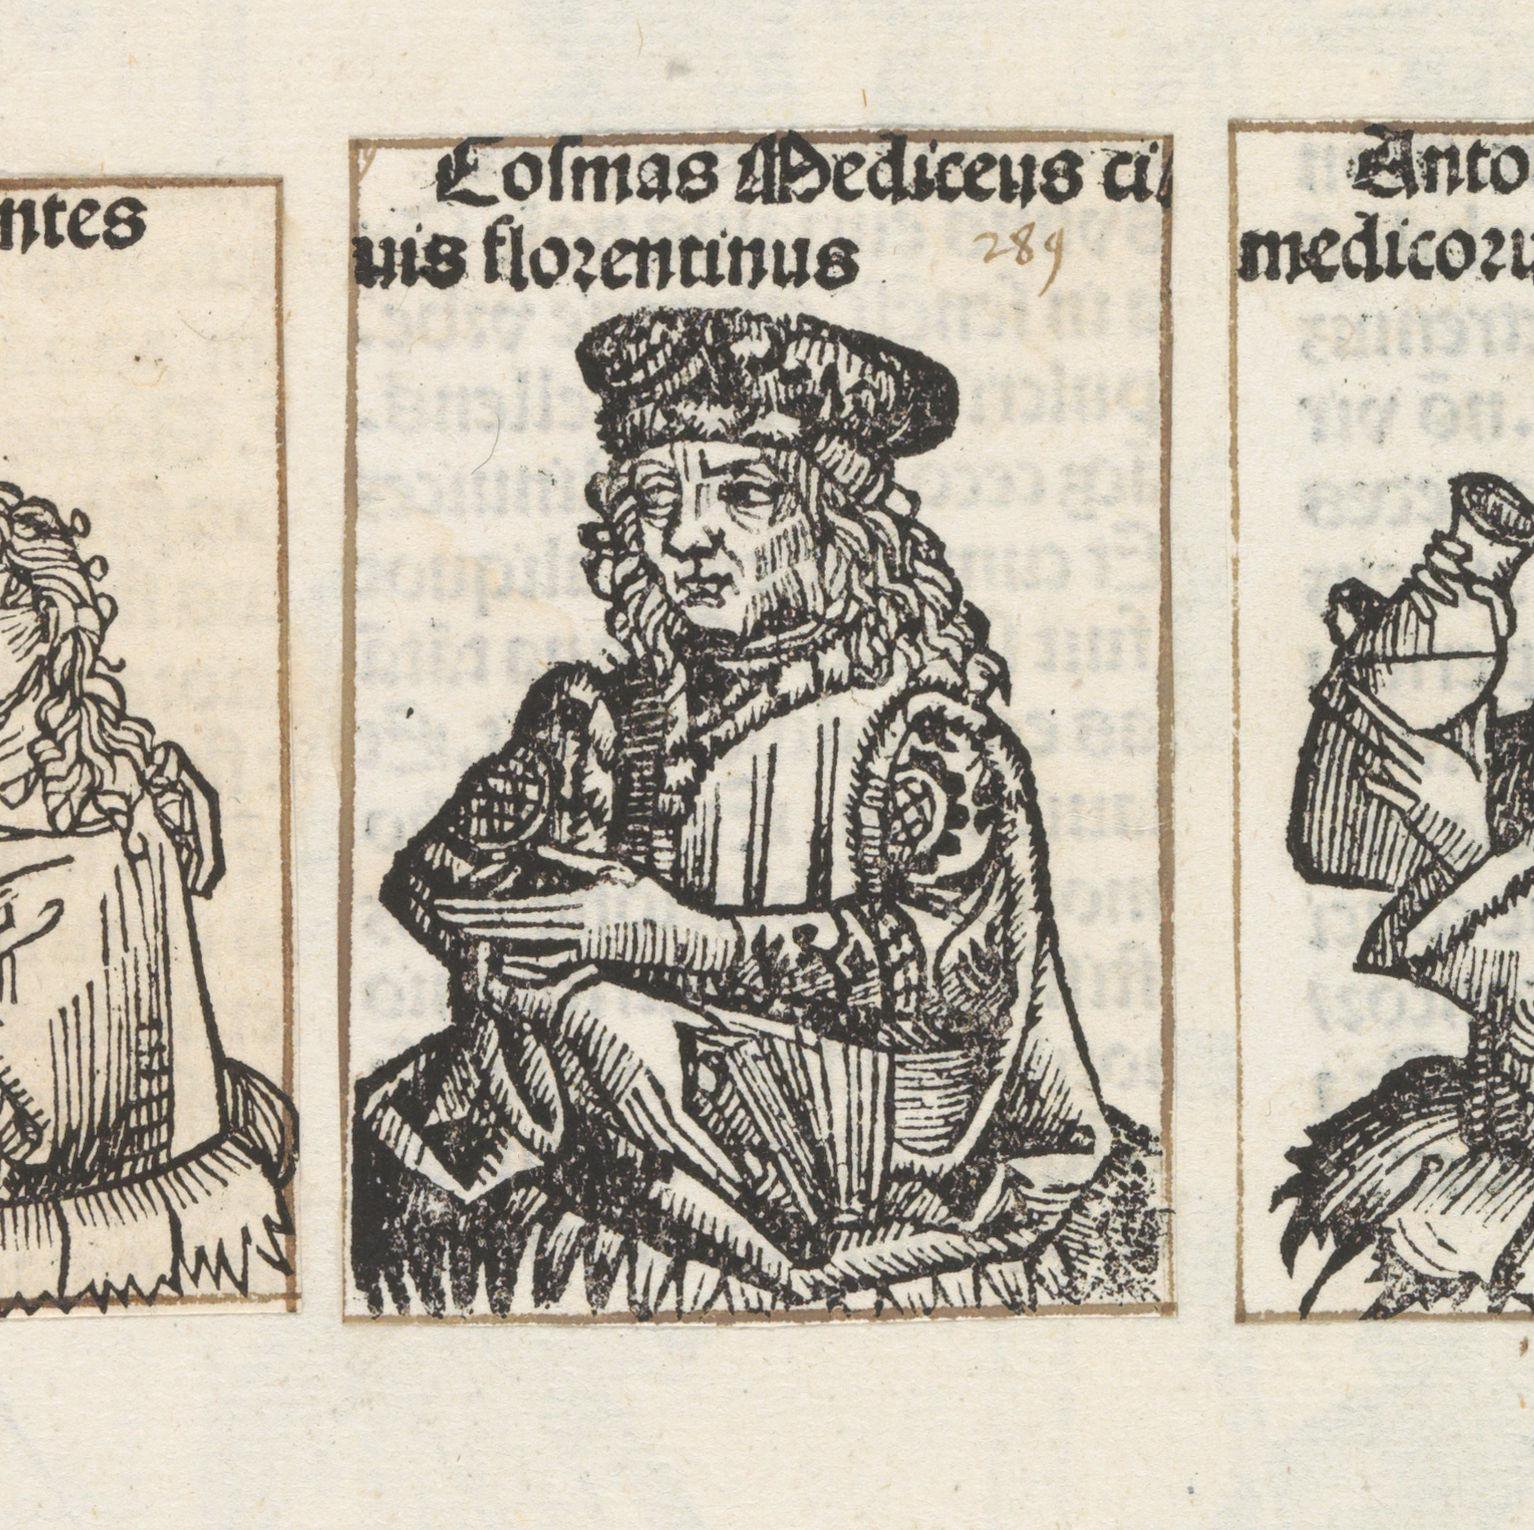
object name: print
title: Cosmas Mediceus civis florentinus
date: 1493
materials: paper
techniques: letterpress printing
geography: nuremberg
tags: politician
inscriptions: inscription: ‘289’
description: De houtsnede wordt herhaaldelijk gebruikt als boekillustratie in de Liber Chronicarum (of Neurenbergkroniek) van Hartmann Schedel, verschenen in het Latijn en Duits in 1493. Zie de Latijnse uitgave, folio 245v.